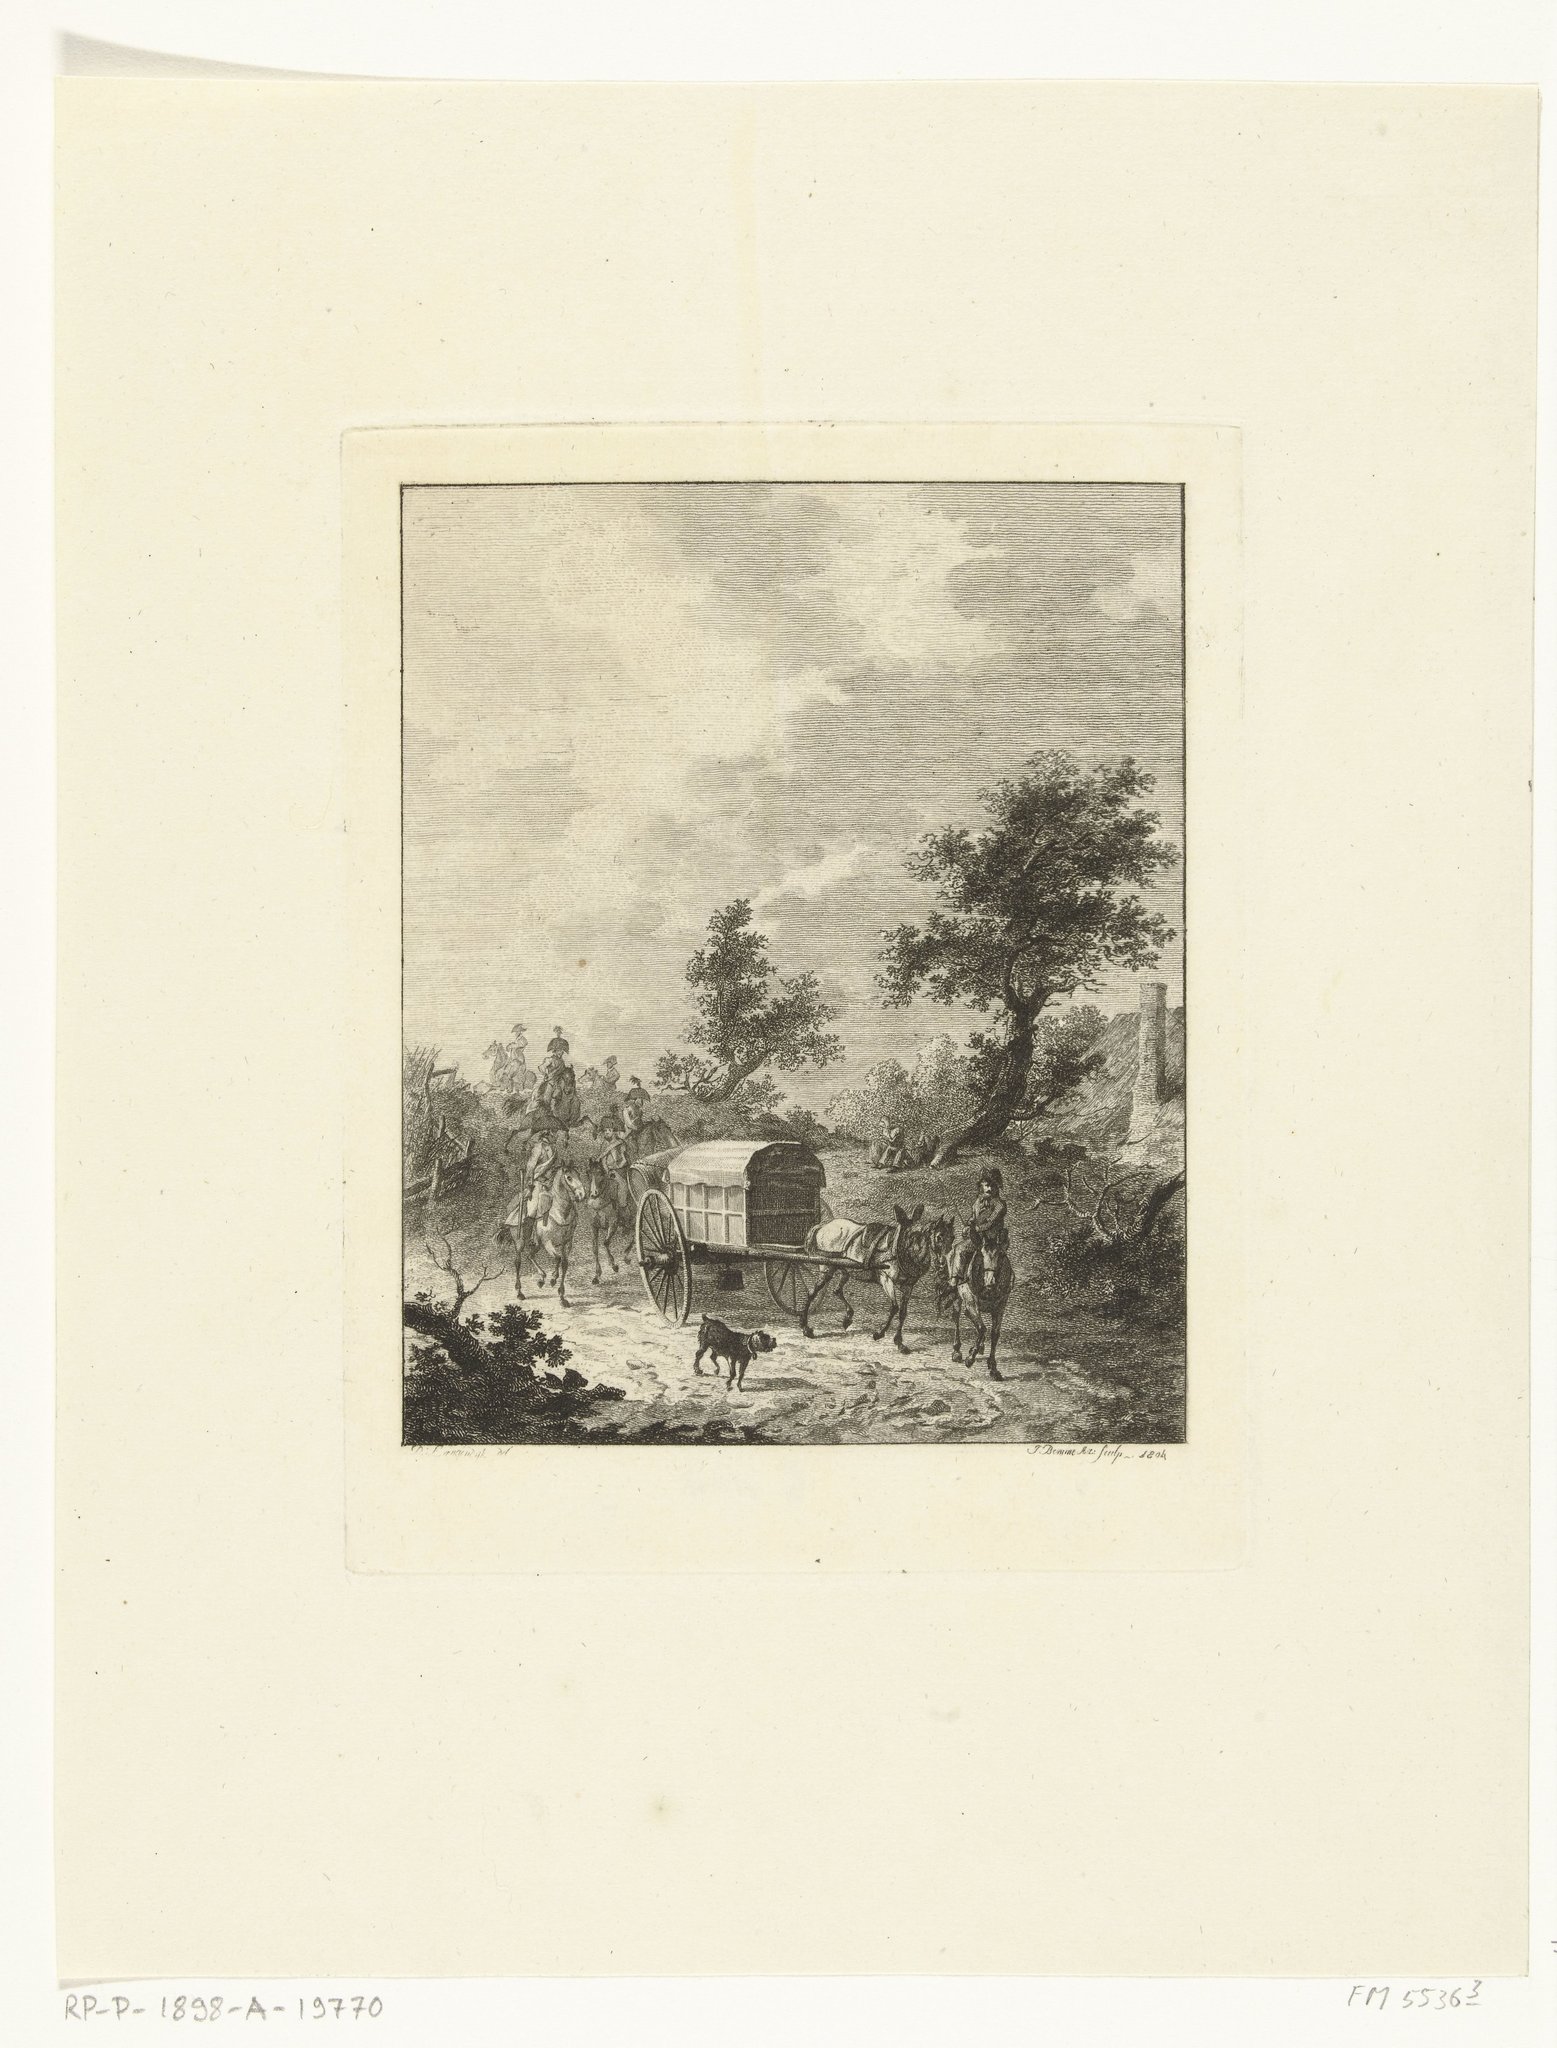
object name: print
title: Zes landschappen met soldatenstaffage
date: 1804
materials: paper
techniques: etching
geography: rotterdam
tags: four-wheeled vehicle drawn by one animal, warfare; military affairs (+ cavalry, horsemen)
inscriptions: collector's mark: Lugt 2228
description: Een groep Napoleontische soldaten rijdt door een duinlandschap. Naar de eerste soldaat rijdt een munitiewagen.